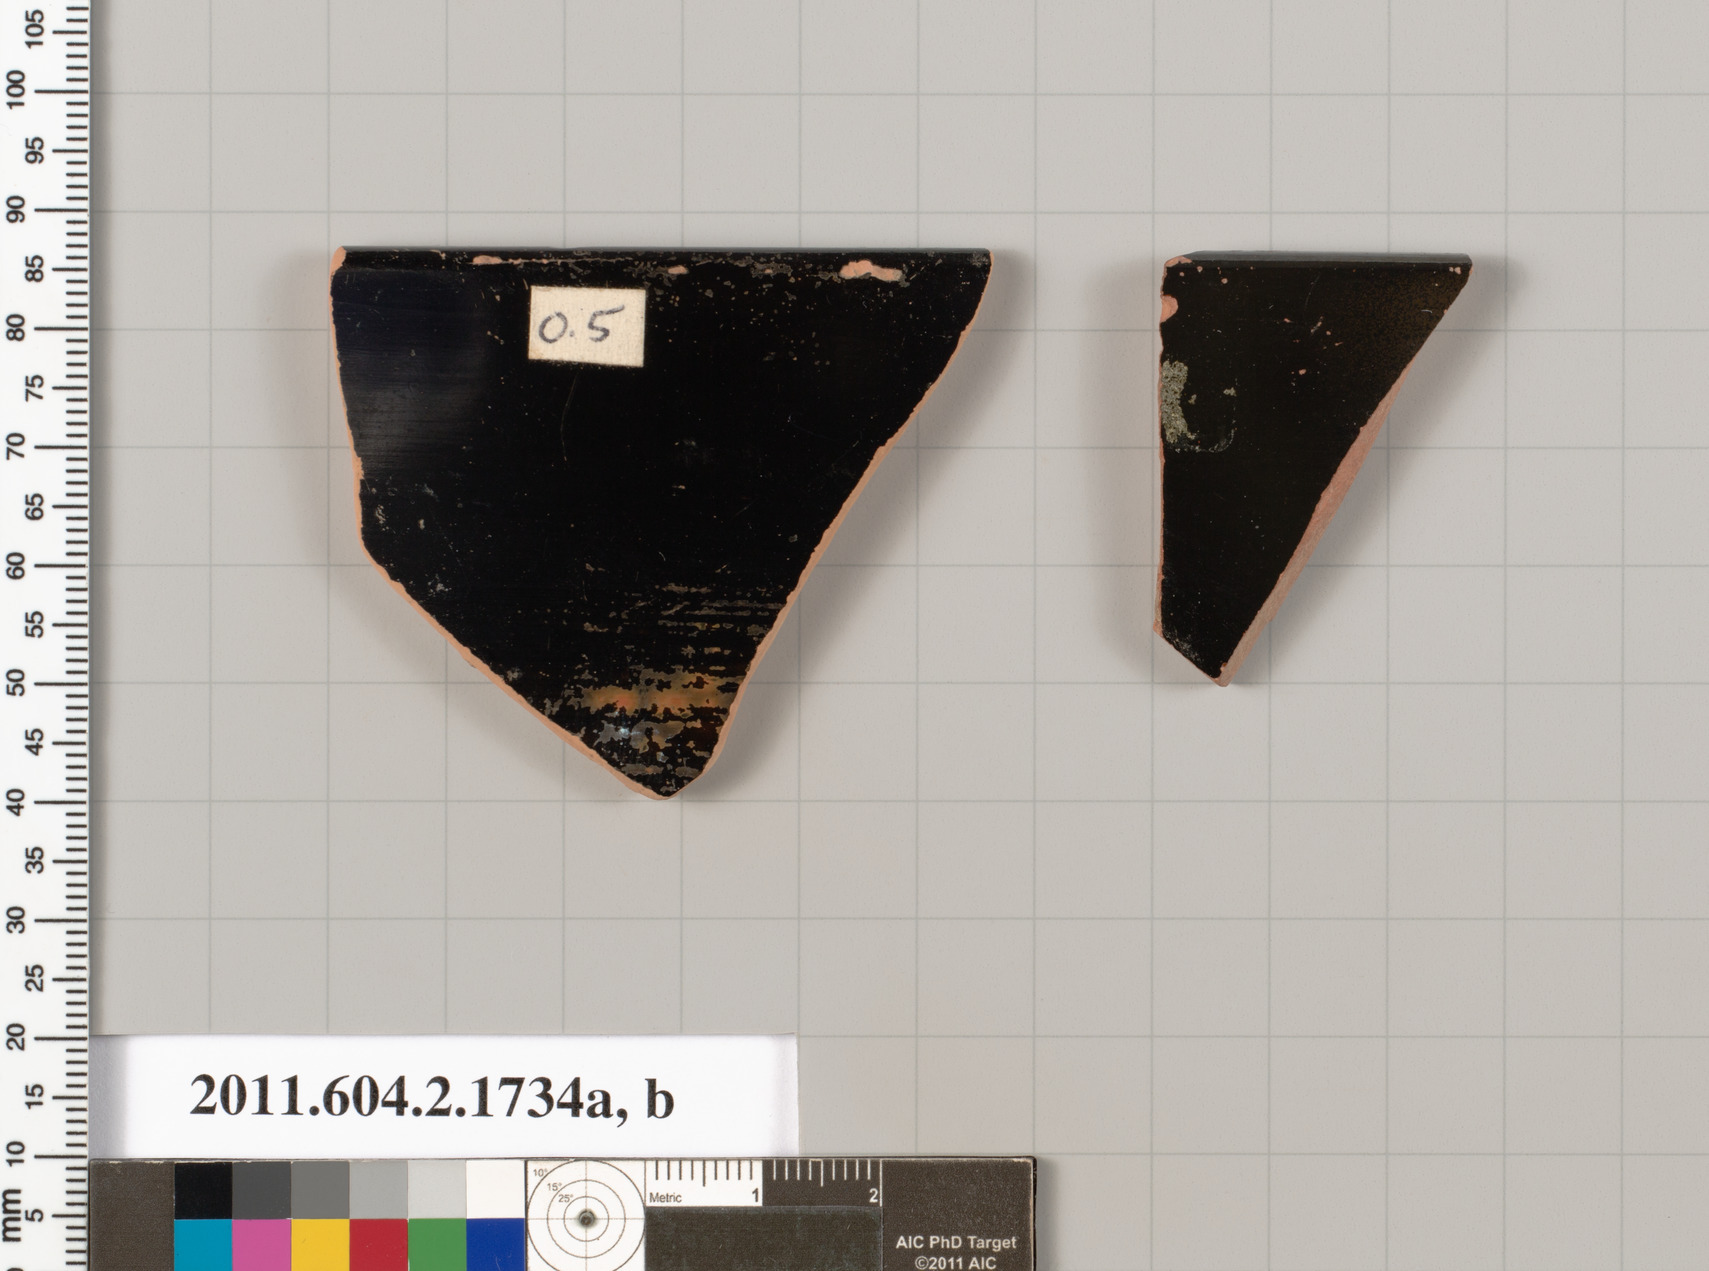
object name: skyphos fragment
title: Terracotta rim fragments of skyphoi (deep drinking cups)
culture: greek, attic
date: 475-451 BCE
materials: terracotta